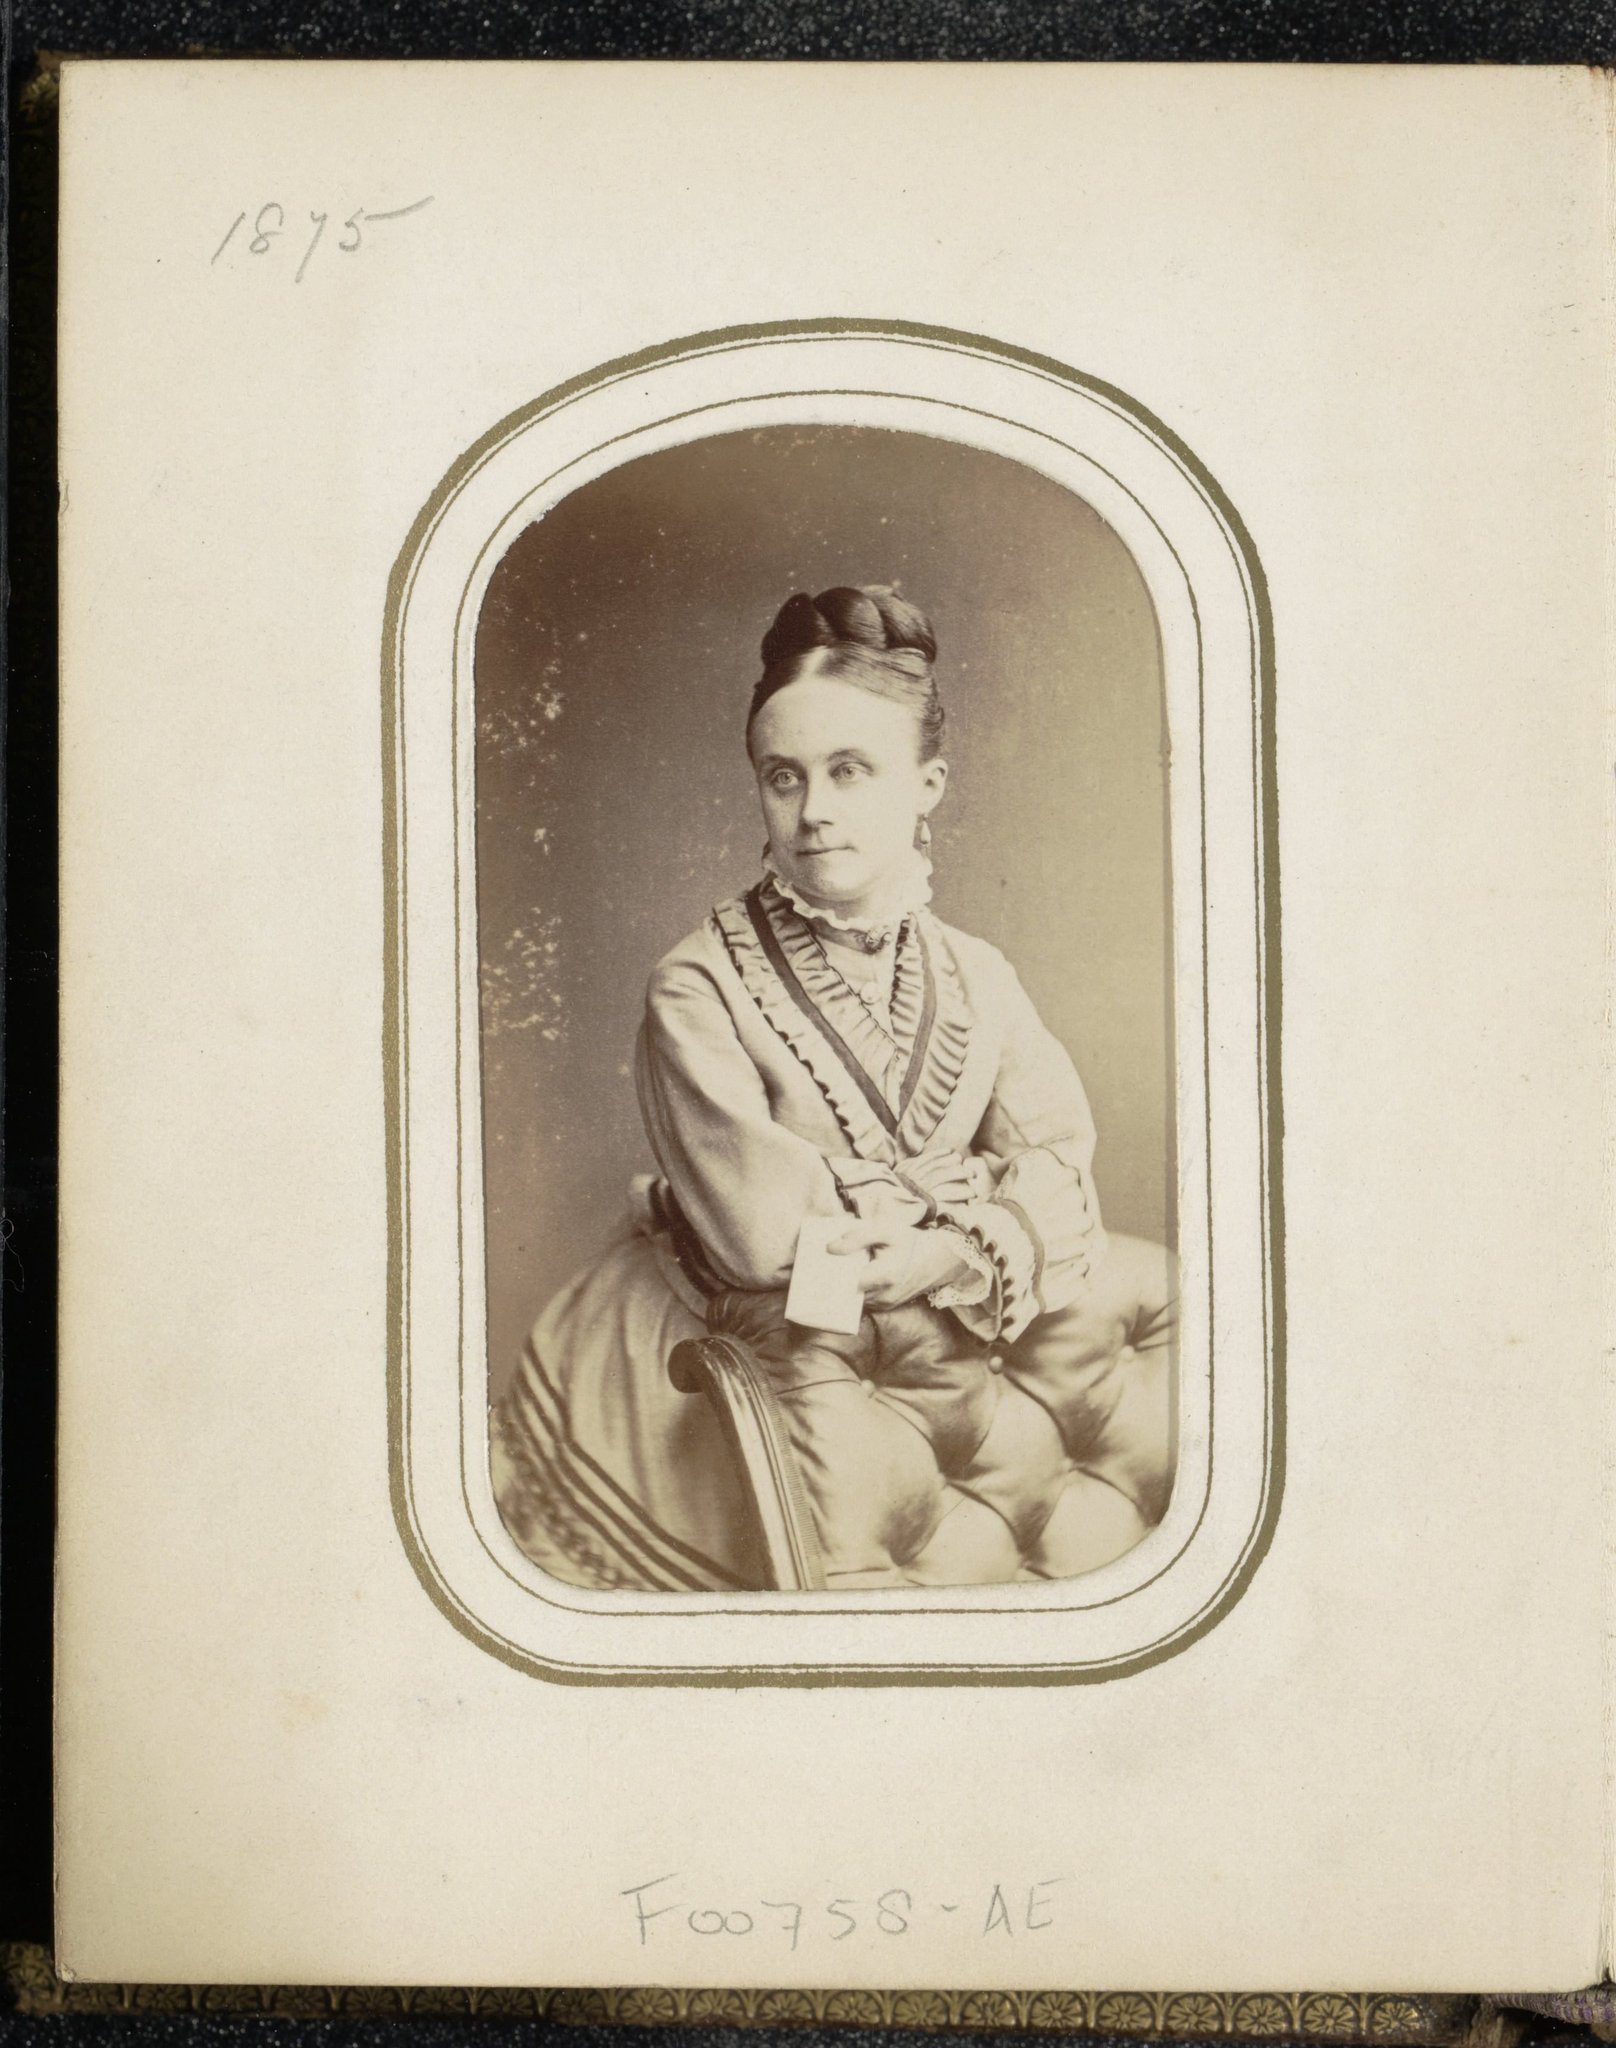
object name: photograph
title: Portret van een vrouw met een briefje in de hand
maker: george glanville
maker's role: fotograaf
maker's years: 1846-1925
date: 1809-1875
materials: cardboard, paper, photographic support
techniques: albumen print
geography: tunbridge wells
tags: studio requisites ~ photographer, historical persons, styles of hairdress - aa - ~ women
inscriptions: address: ‘Tunbridge Wells, 5 High Street’, inscription: ‘1875’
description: Onderdeel van Engels fotoalbum van E.A. Kettle met 42 cartes-de-visite.